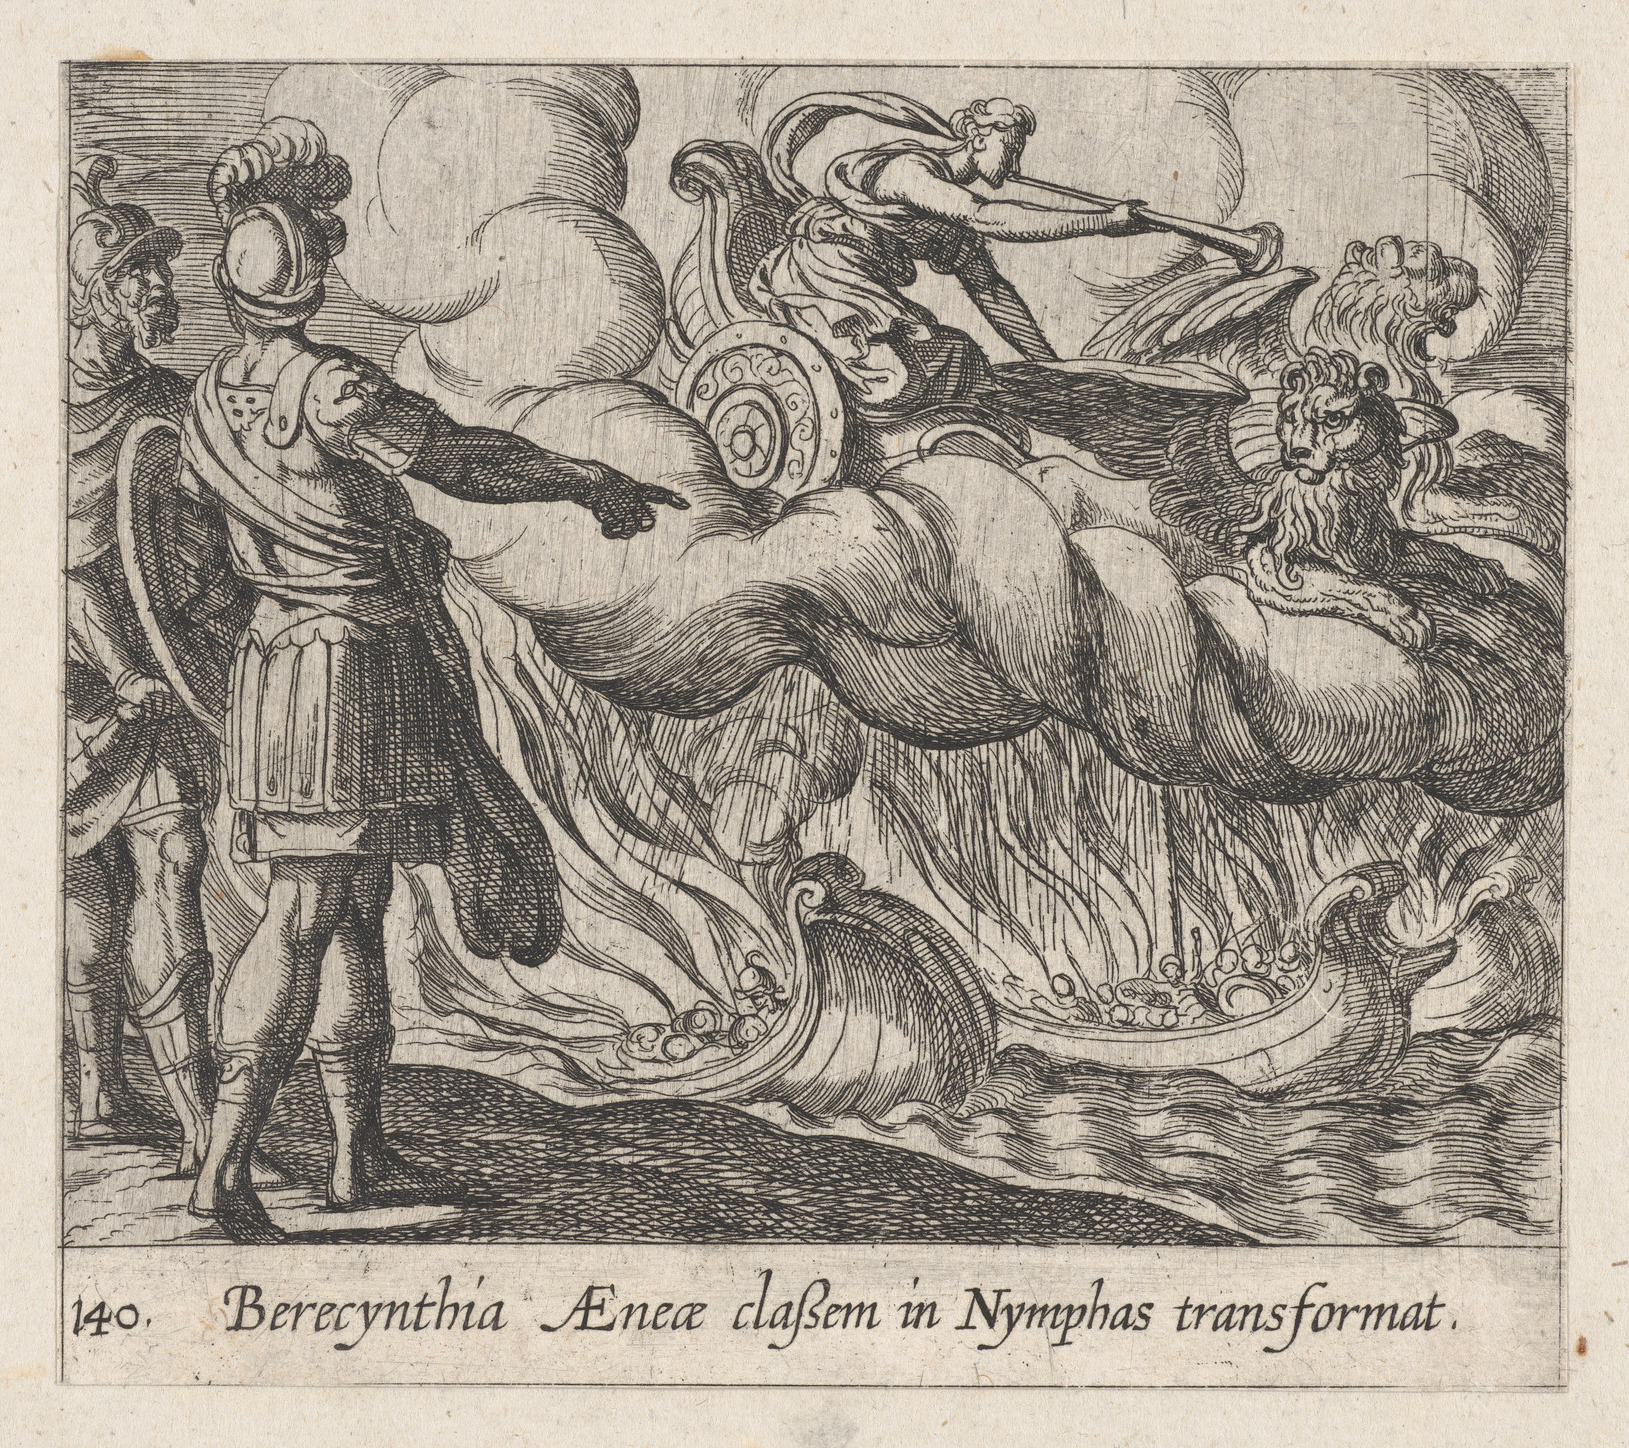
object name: print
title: Plate 140: The Trojan Ships Changed into Nymphs (Berecynthia AEneae classem in Nymphas transformat), from Ovid's 'Metamorphoses'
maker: antonio tempesta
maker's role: artist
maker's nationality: italian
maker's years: 1555-1630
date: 1606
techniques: etching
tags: nymphs,ships